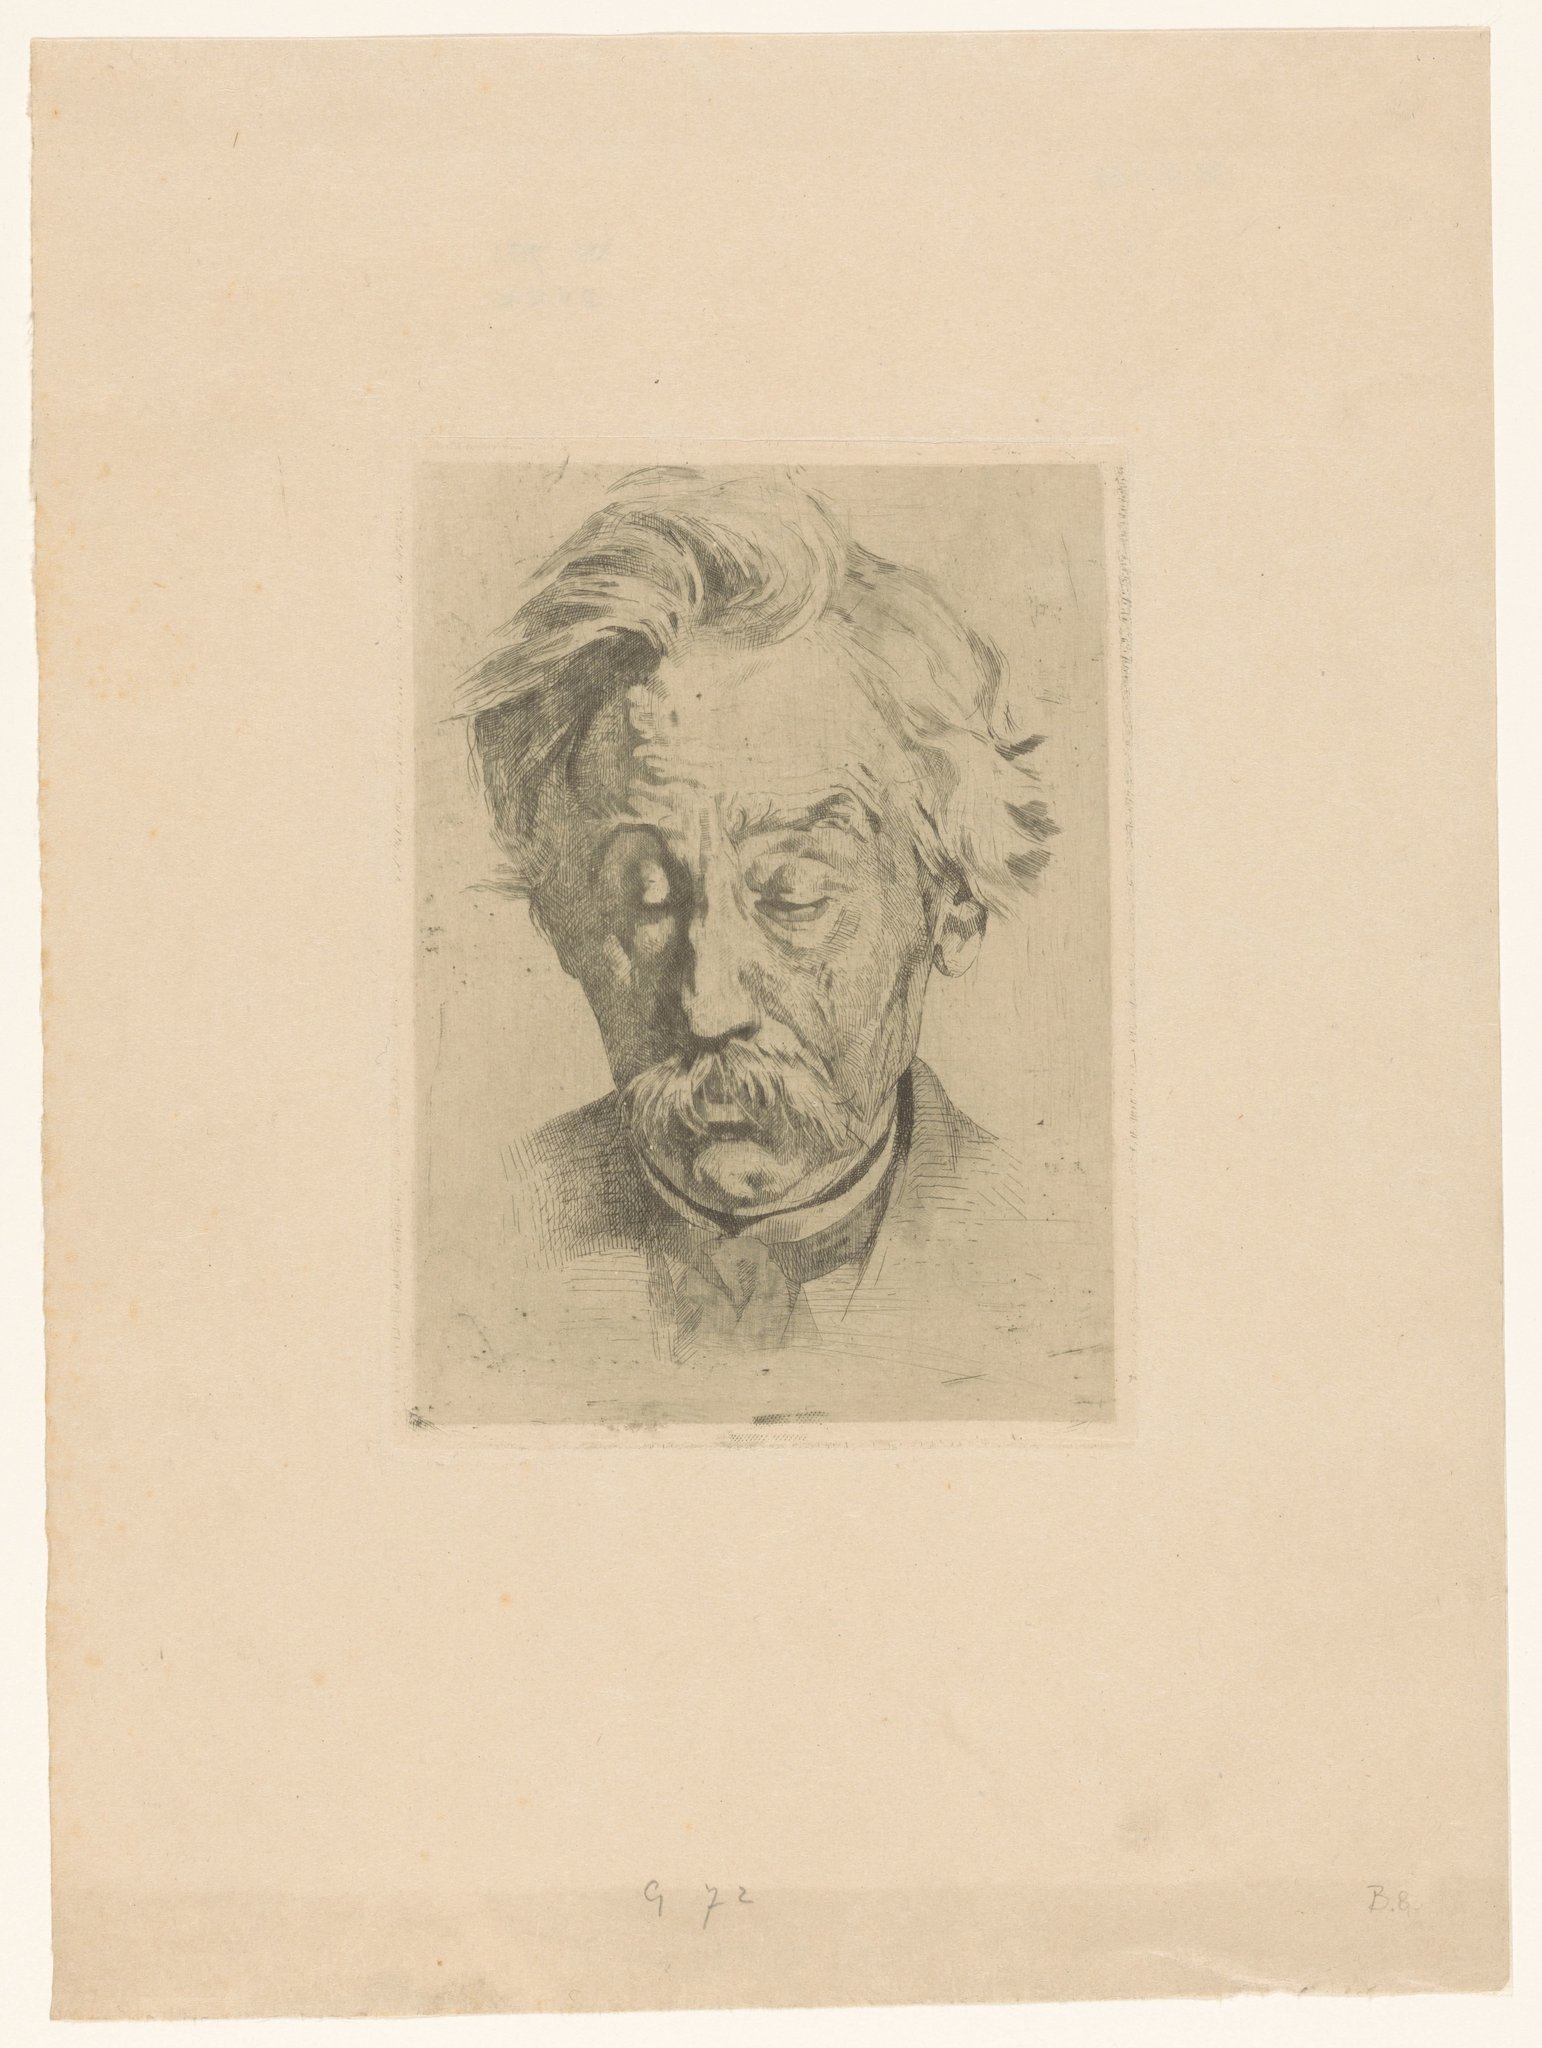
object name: print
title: Portret van dr. Jacob Christiaan Muller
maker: willem witsen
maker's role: draughtsman, painter, print maker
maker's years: 1860-1923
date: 1884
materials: paper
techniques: etching, intaglio, roulette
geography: ewijkshoeve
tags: historical persons